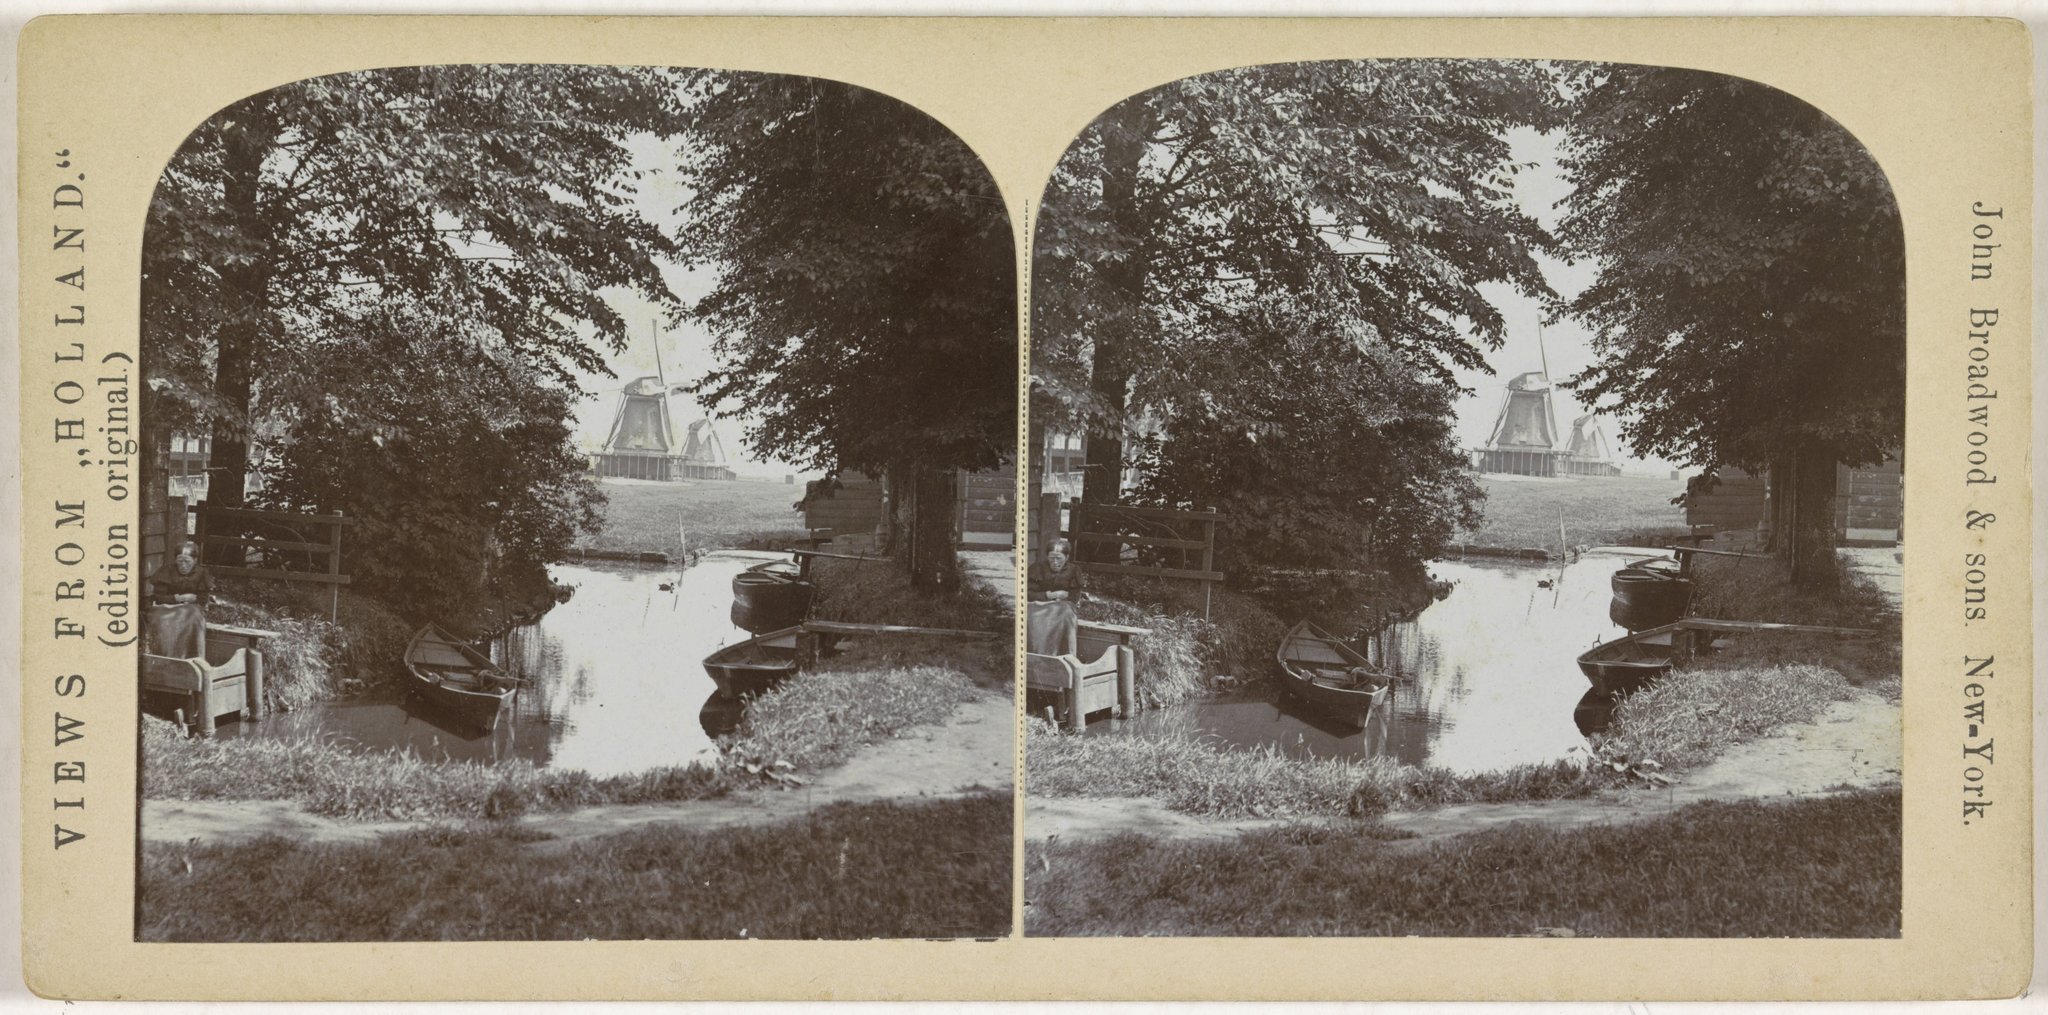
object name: stereograph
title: Views from 'Holland'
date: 1880-1920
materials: cardboard, paper, photographic support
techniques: gelatin silver print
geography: new york city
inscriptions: number: ‘25’, inscription: ‘VIEWS FROM ''HOLLAND'' (edition original.)’